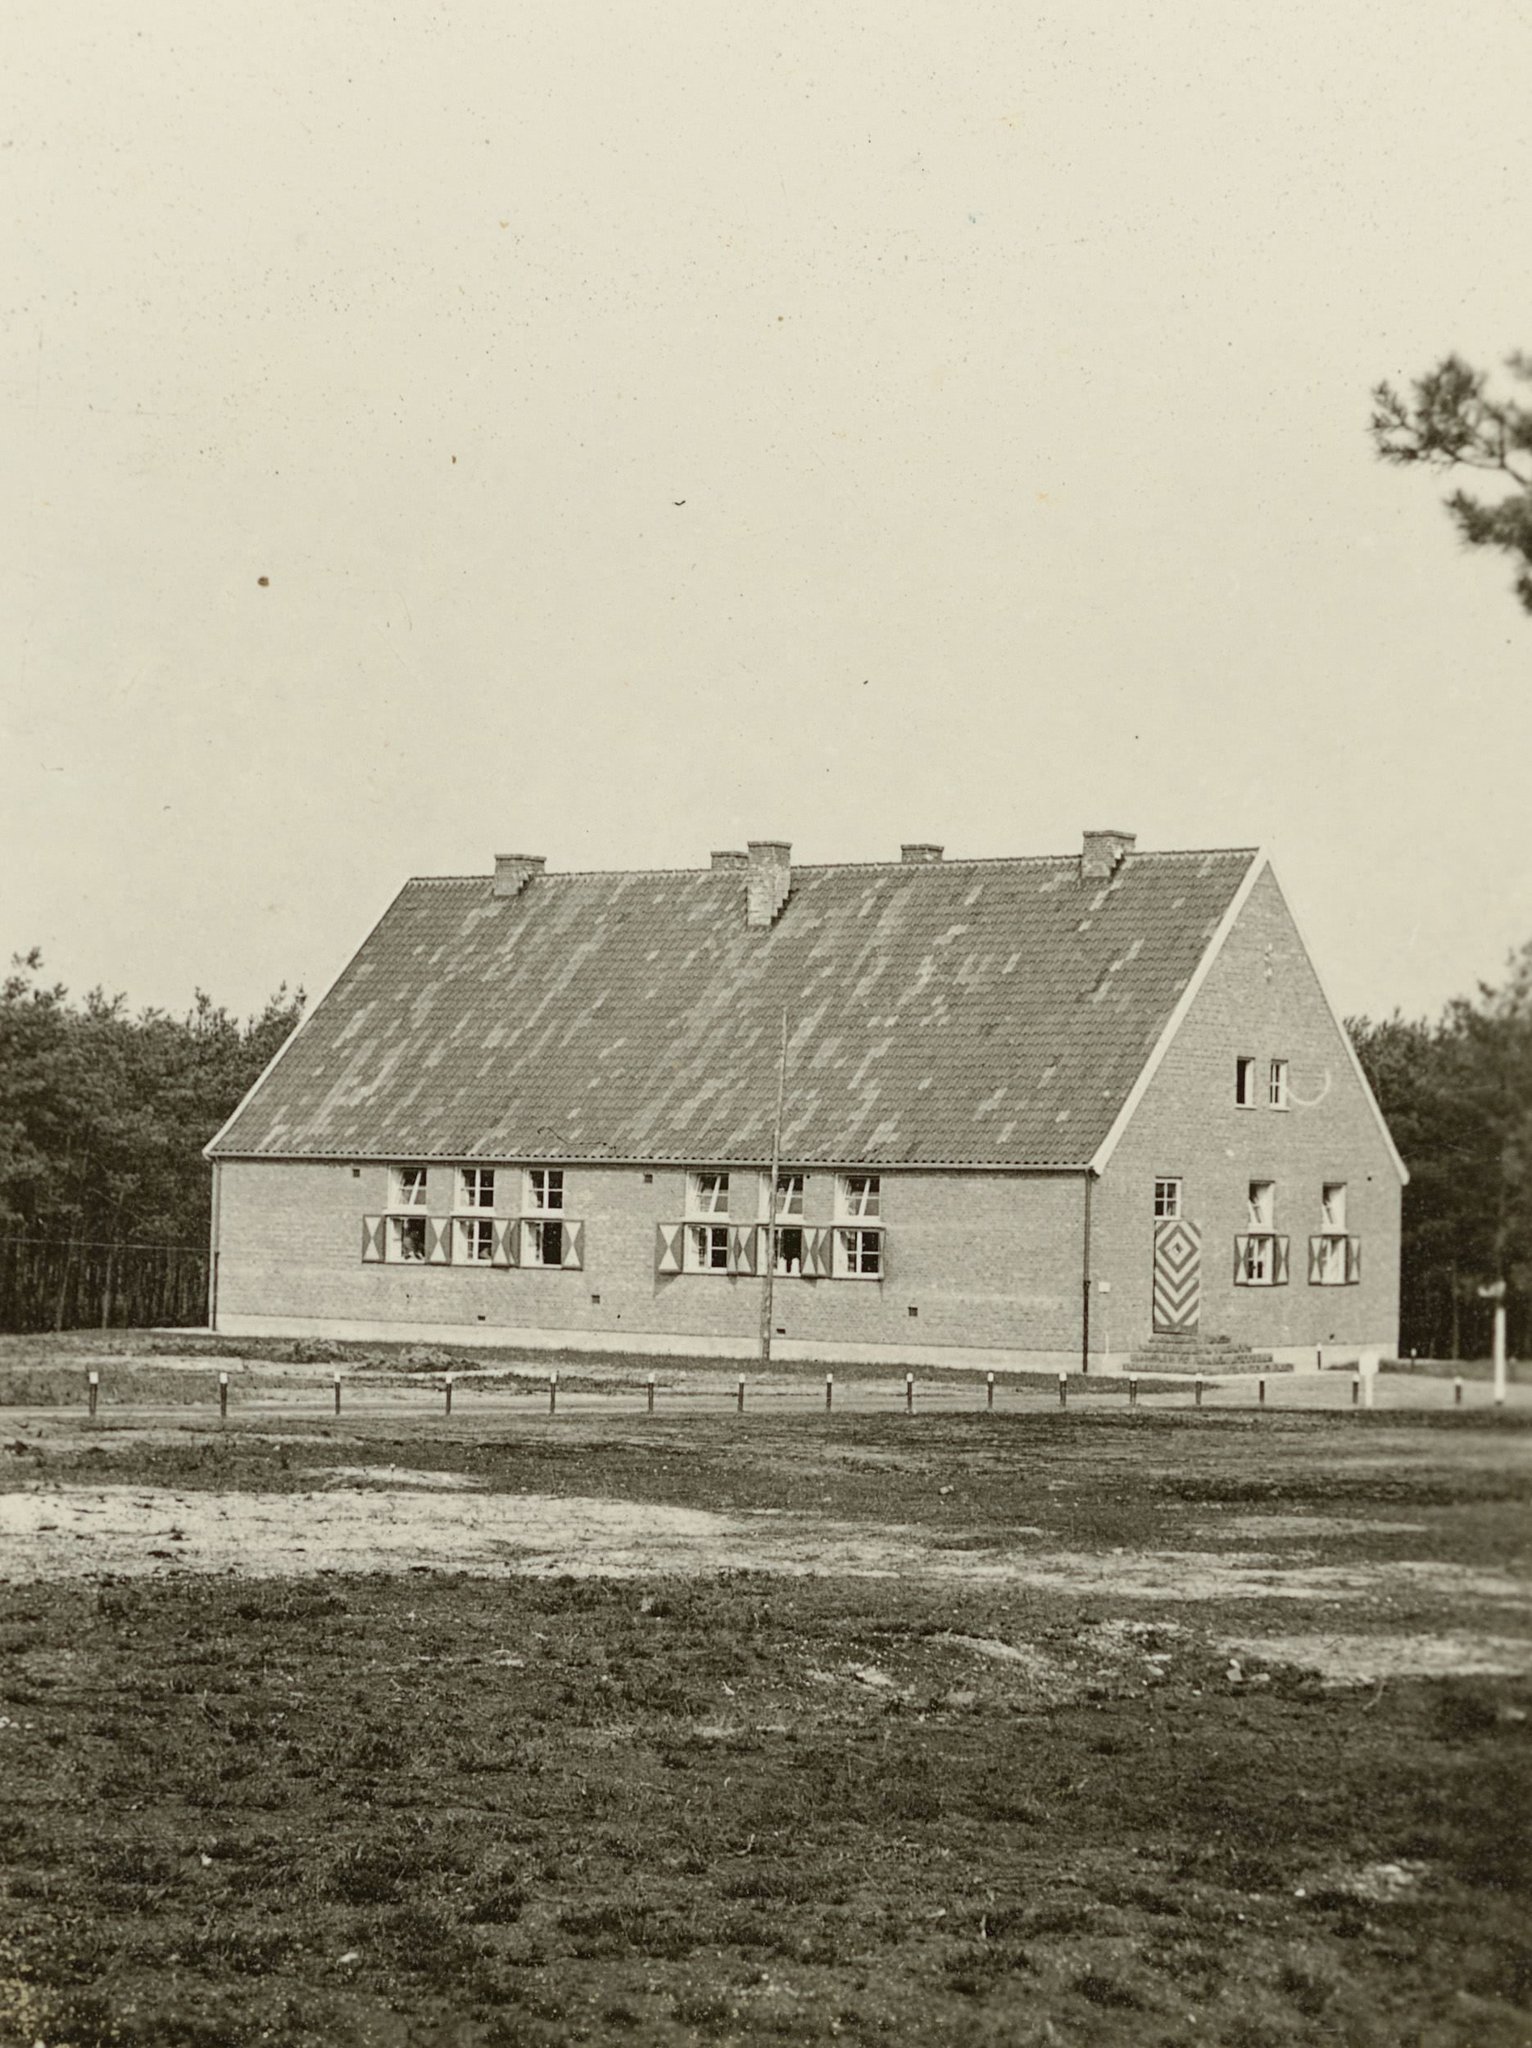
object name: photograph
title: Huis met luiken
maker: Anonymous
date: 1941-1942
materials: photographic support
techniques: gelatin silver print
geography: netherlands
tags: occupation ~ war, netherlands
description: Een huis van baksteen met luiken in een weiland. Deur in streepmotief.